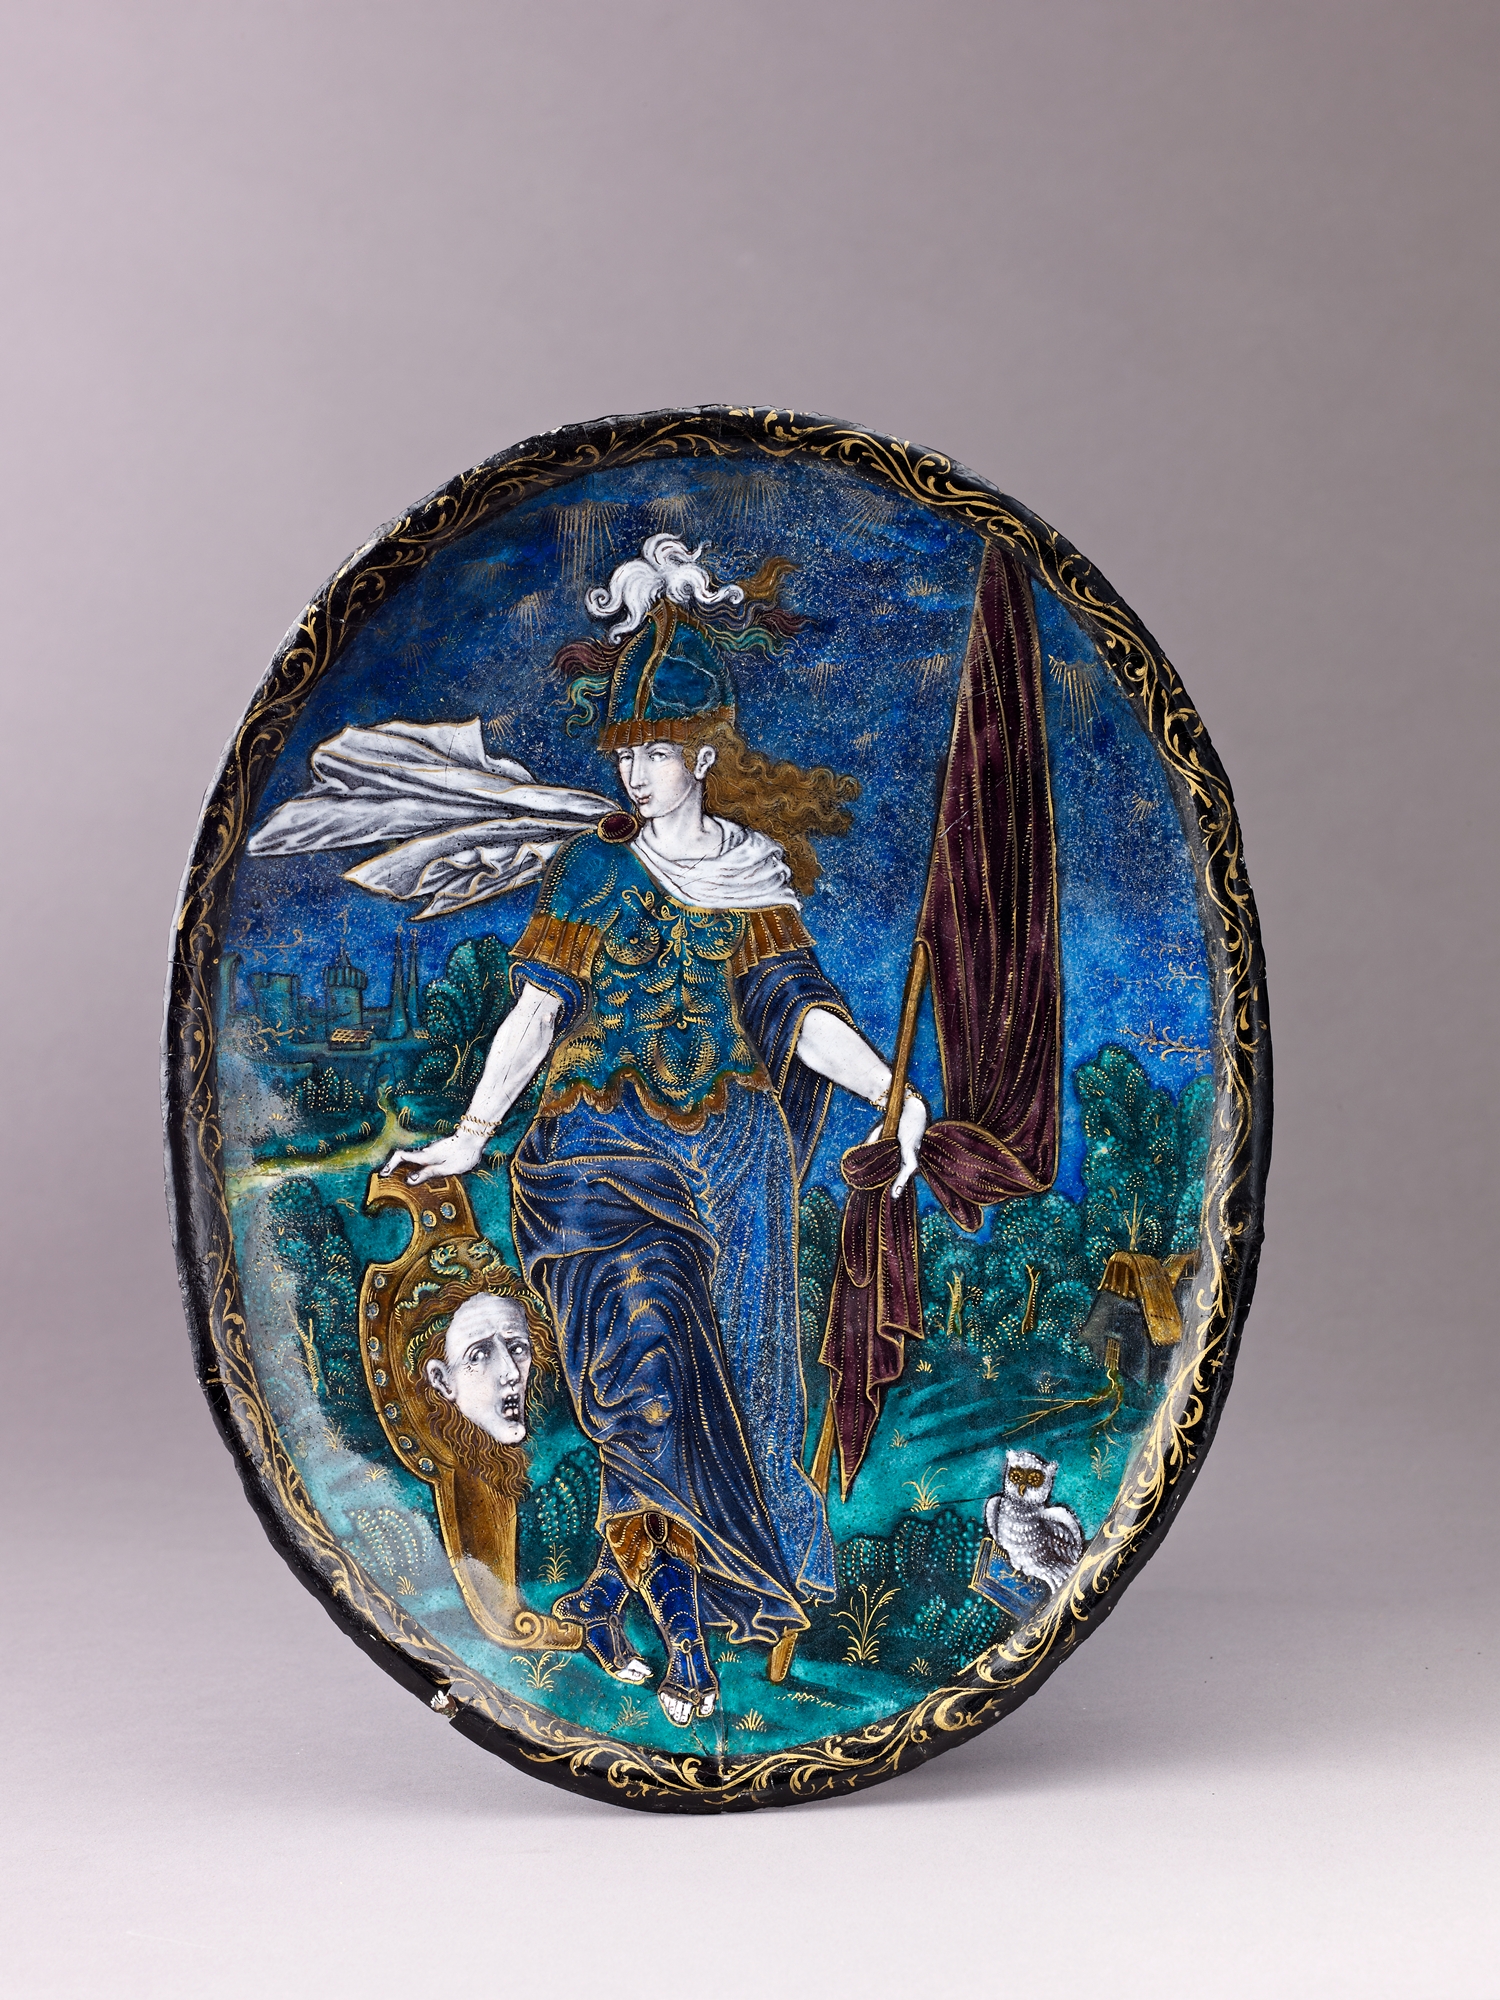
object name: plaque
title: Minerva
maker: jean limosin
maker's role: artist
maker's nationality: french, limoges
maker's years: 1580-1646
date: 1605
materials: copper, enamel, gilt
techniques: painting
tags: heads,minerva,owls